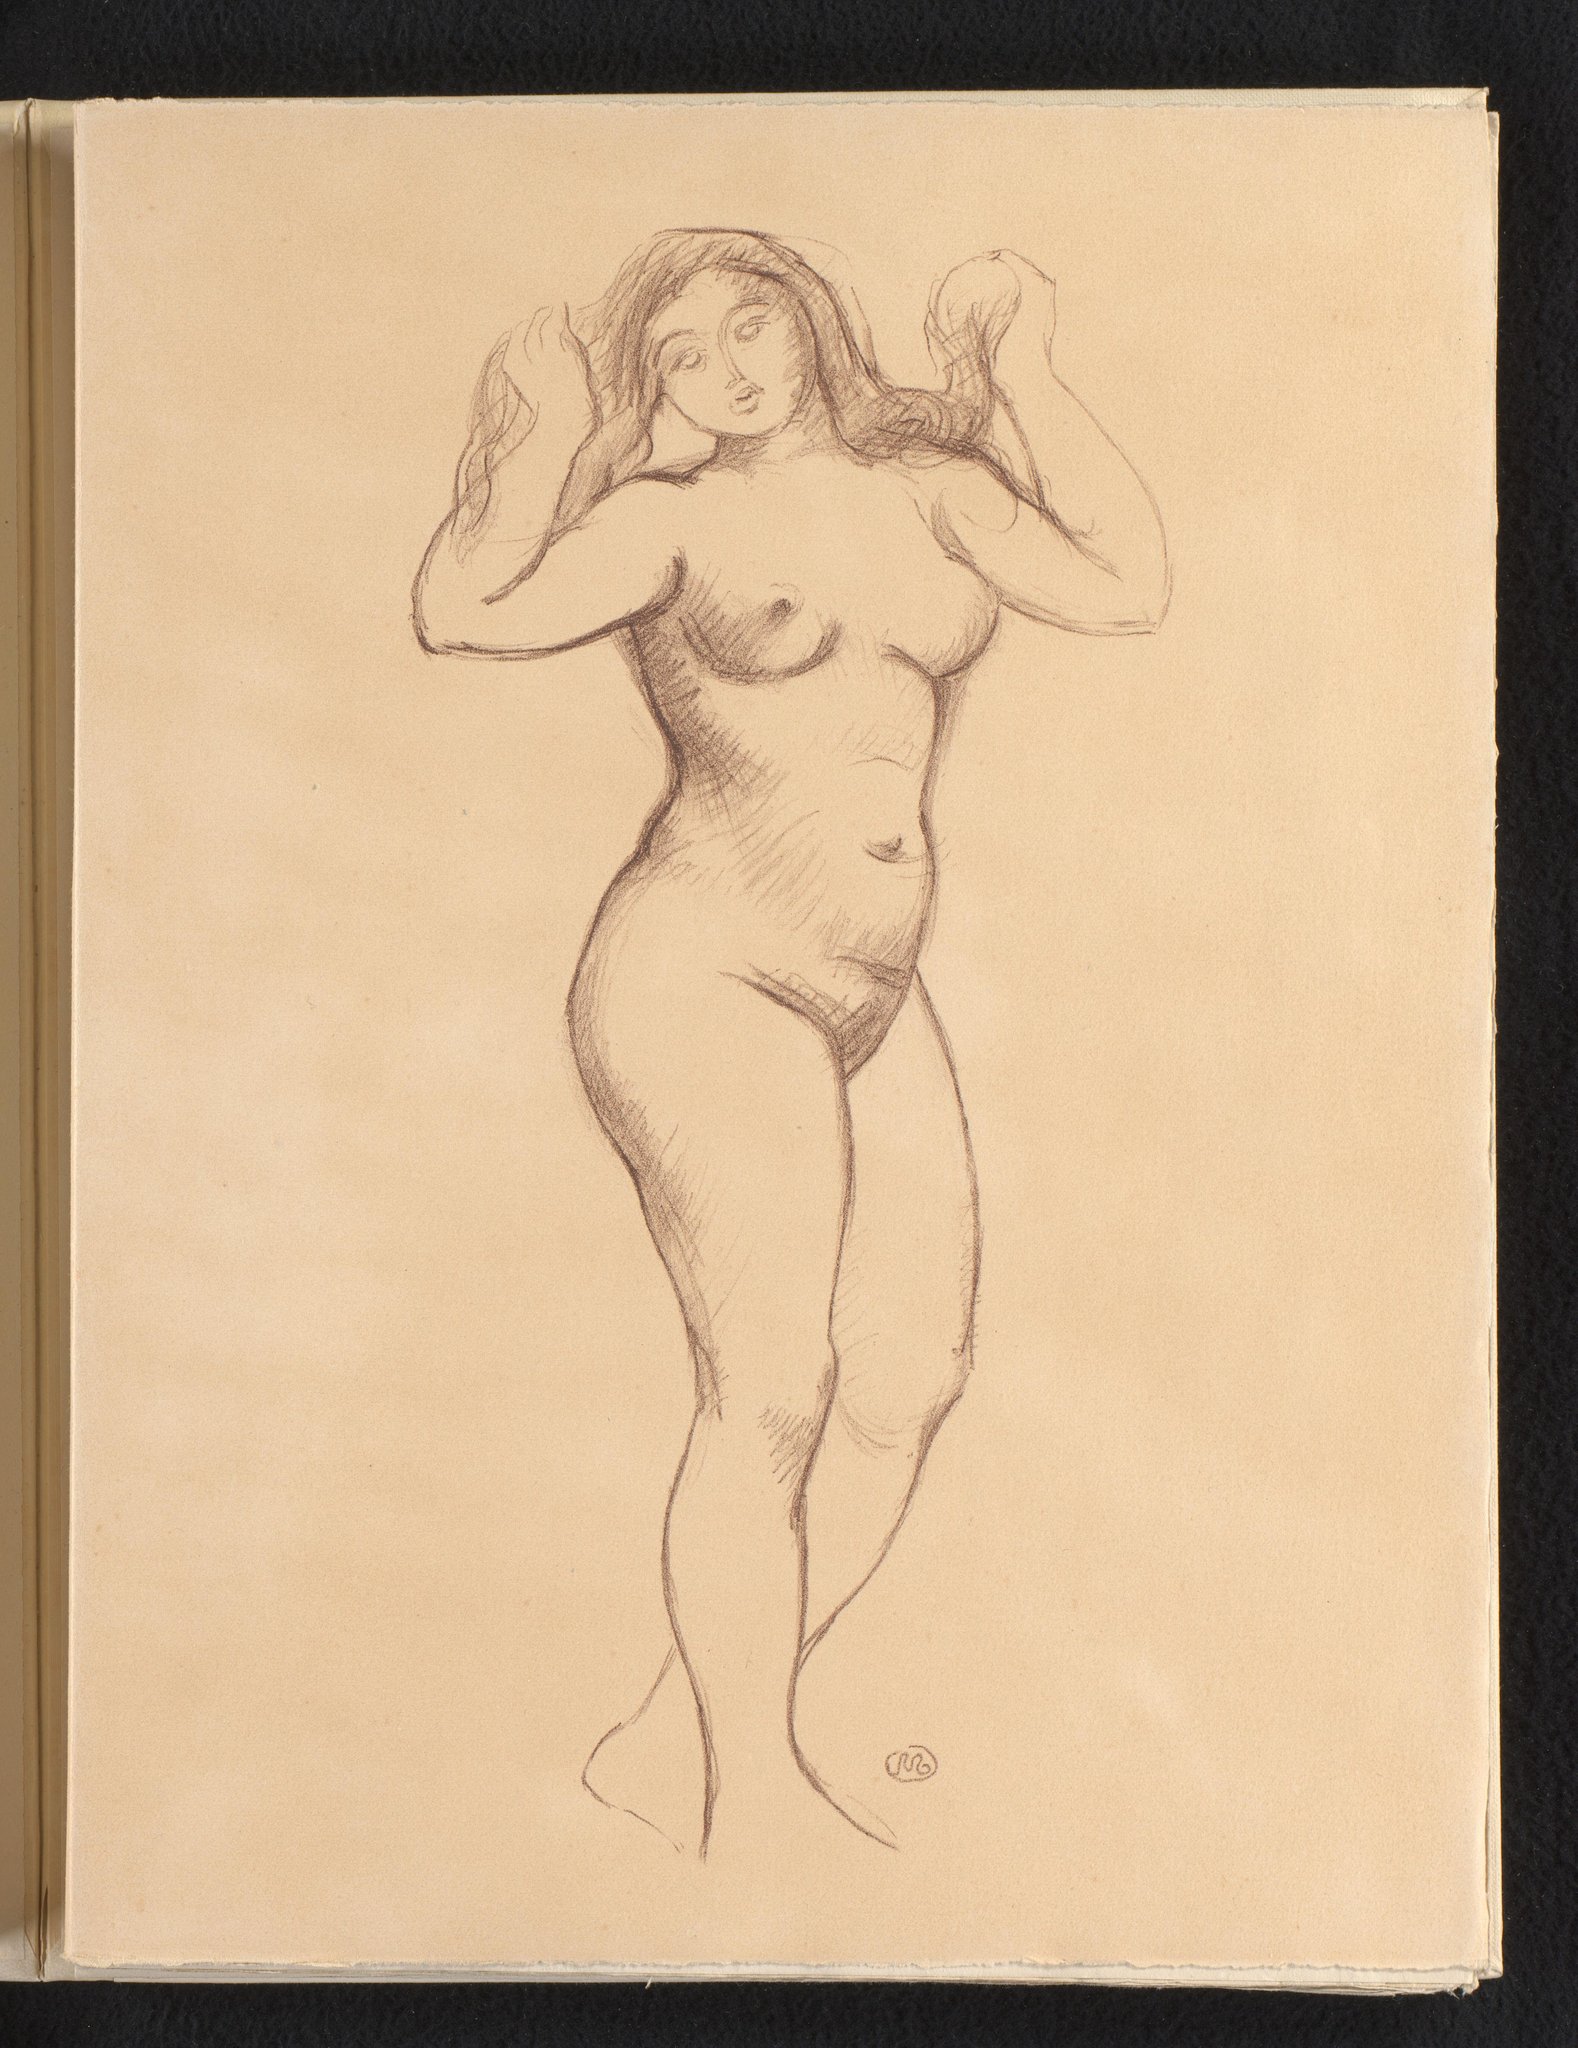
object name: wrapper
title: Omslag voor de extra suite van 35 lithografieën bij 'Dialogues des Courtisanes' door Lucianus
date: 1948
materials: paper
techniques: lithograph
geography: paris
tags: print, e.g.: engraving, etching, lithograph, woman (showing herself) undressed, quasi-nude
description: Omslag voor: Lucianus van Samosata. Dialogues des Courtisanes. [Vertaald uit het Grieks door] Charles Astruc. Parijs: s.n., 1948. Uitgegeven met medewerking van Henri Creuzevault en Dina Vierny. Gedrukt in een oplage van 275 genummerde exemplaren. Hiervan zijn de eerste vijftig vergezeld van een tweede suite van de prenten in sanguine. De lithografieën werden onder toezicht van Fernard Mourlot gedrukt, de tekst werd gedrukt door Pierre Bricage. De publicatie werd gedrukt op speciaal papier van pure hennep naar een procedé van Maillol. Alle lithostenen zijn na het drukken vernietigd.